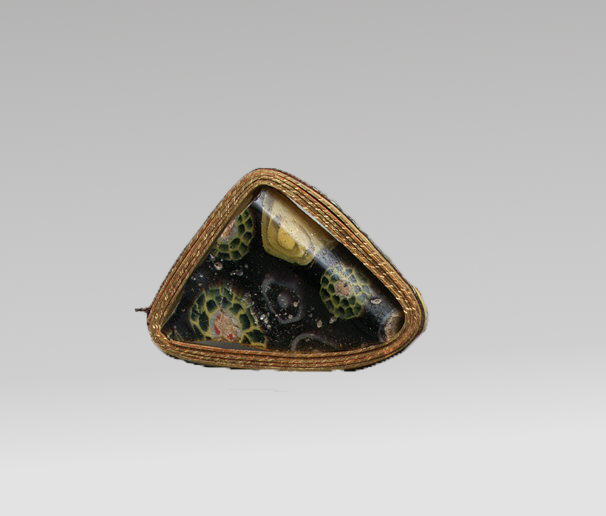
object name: fragment, mosaic bowl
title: Glass mosaic carinated bowl fragment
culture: roman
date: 34 BCE-33 CE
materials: glass